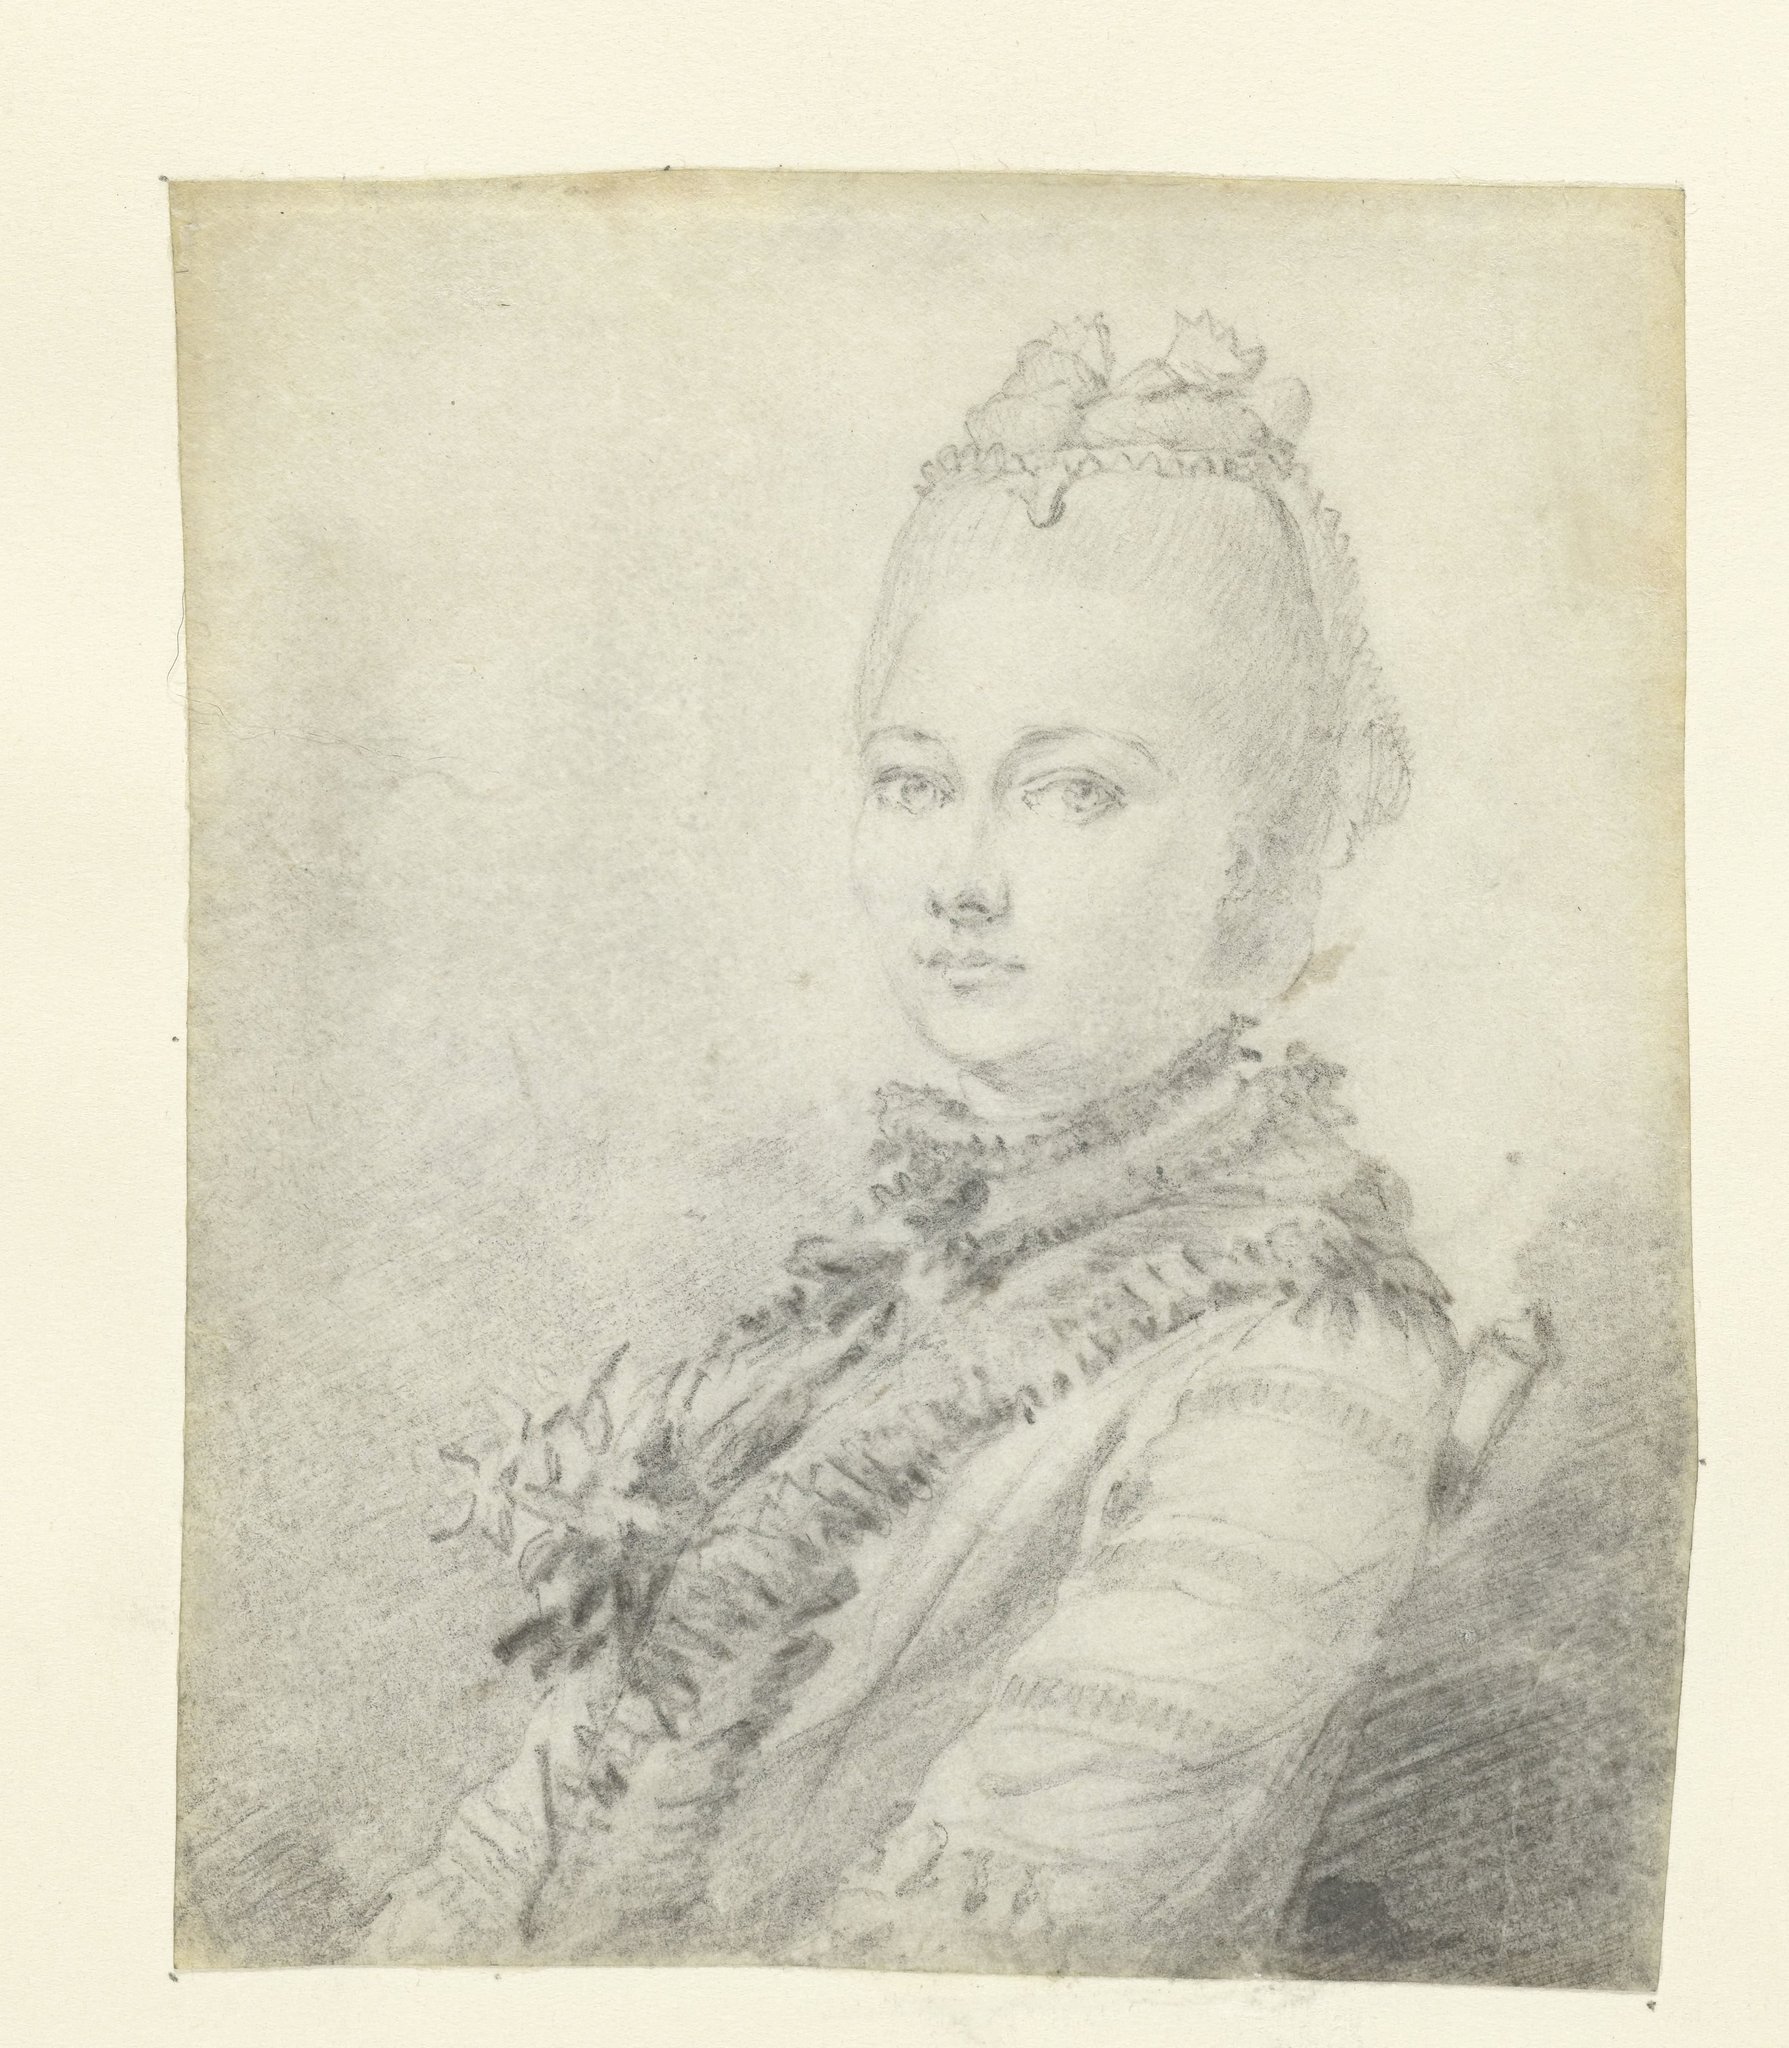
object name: drawing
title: Vrouwenportret, buste naar links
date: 1700-1800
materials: parchment, pencil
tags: historical persons - bb - woman